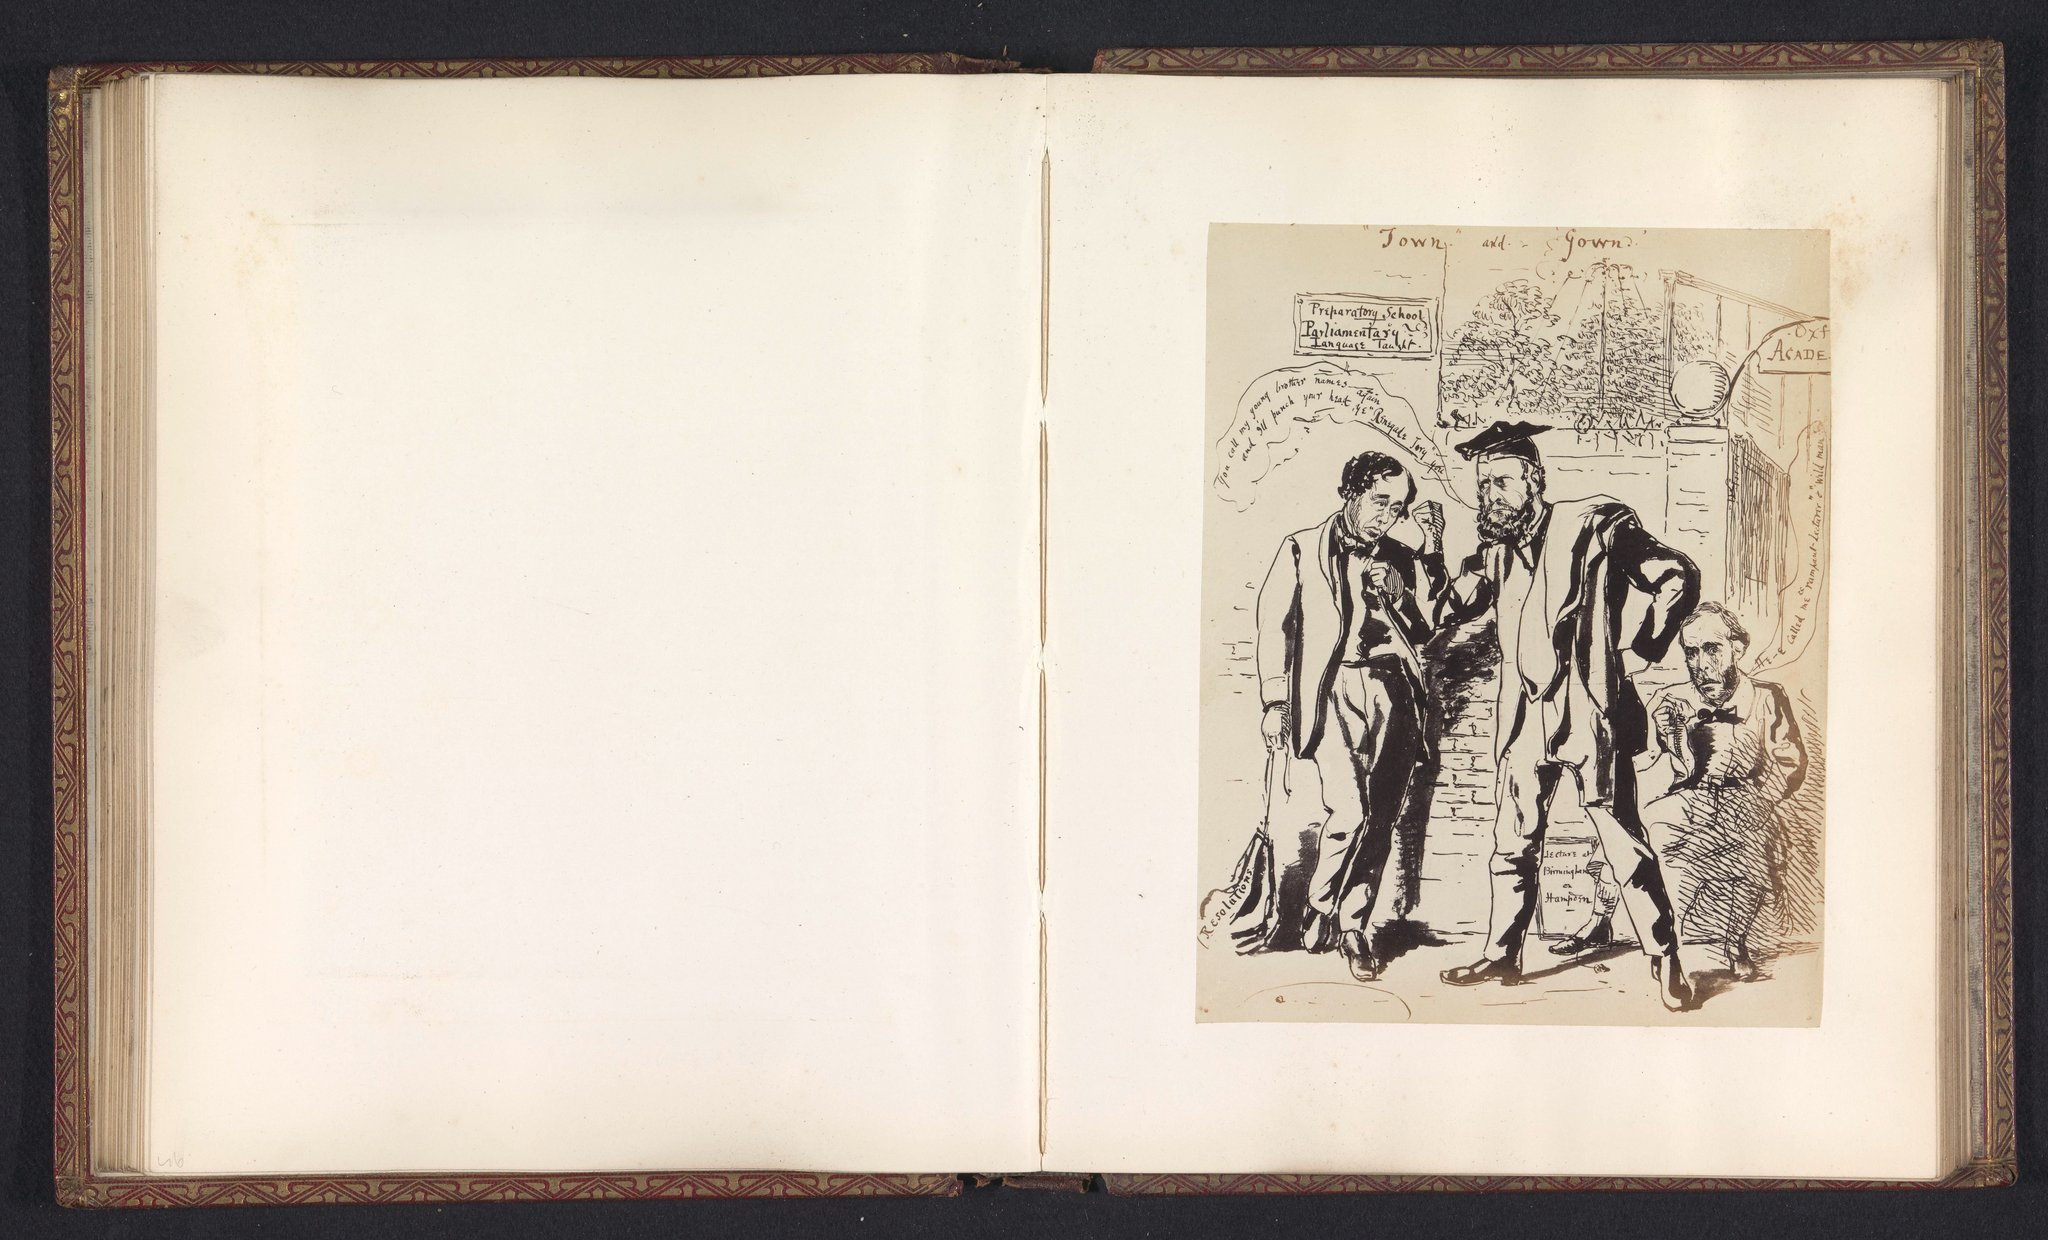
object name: photograph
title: Fotoreproductie van een tekening, voorstellende professor Rogers verdedigt Mr. Goldwin Smith tegen Mr. Disraeli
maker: Anonymous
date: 1855-1866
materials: photographic support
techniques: albumen print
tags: caricatures (human types), quarrel, argument, student life